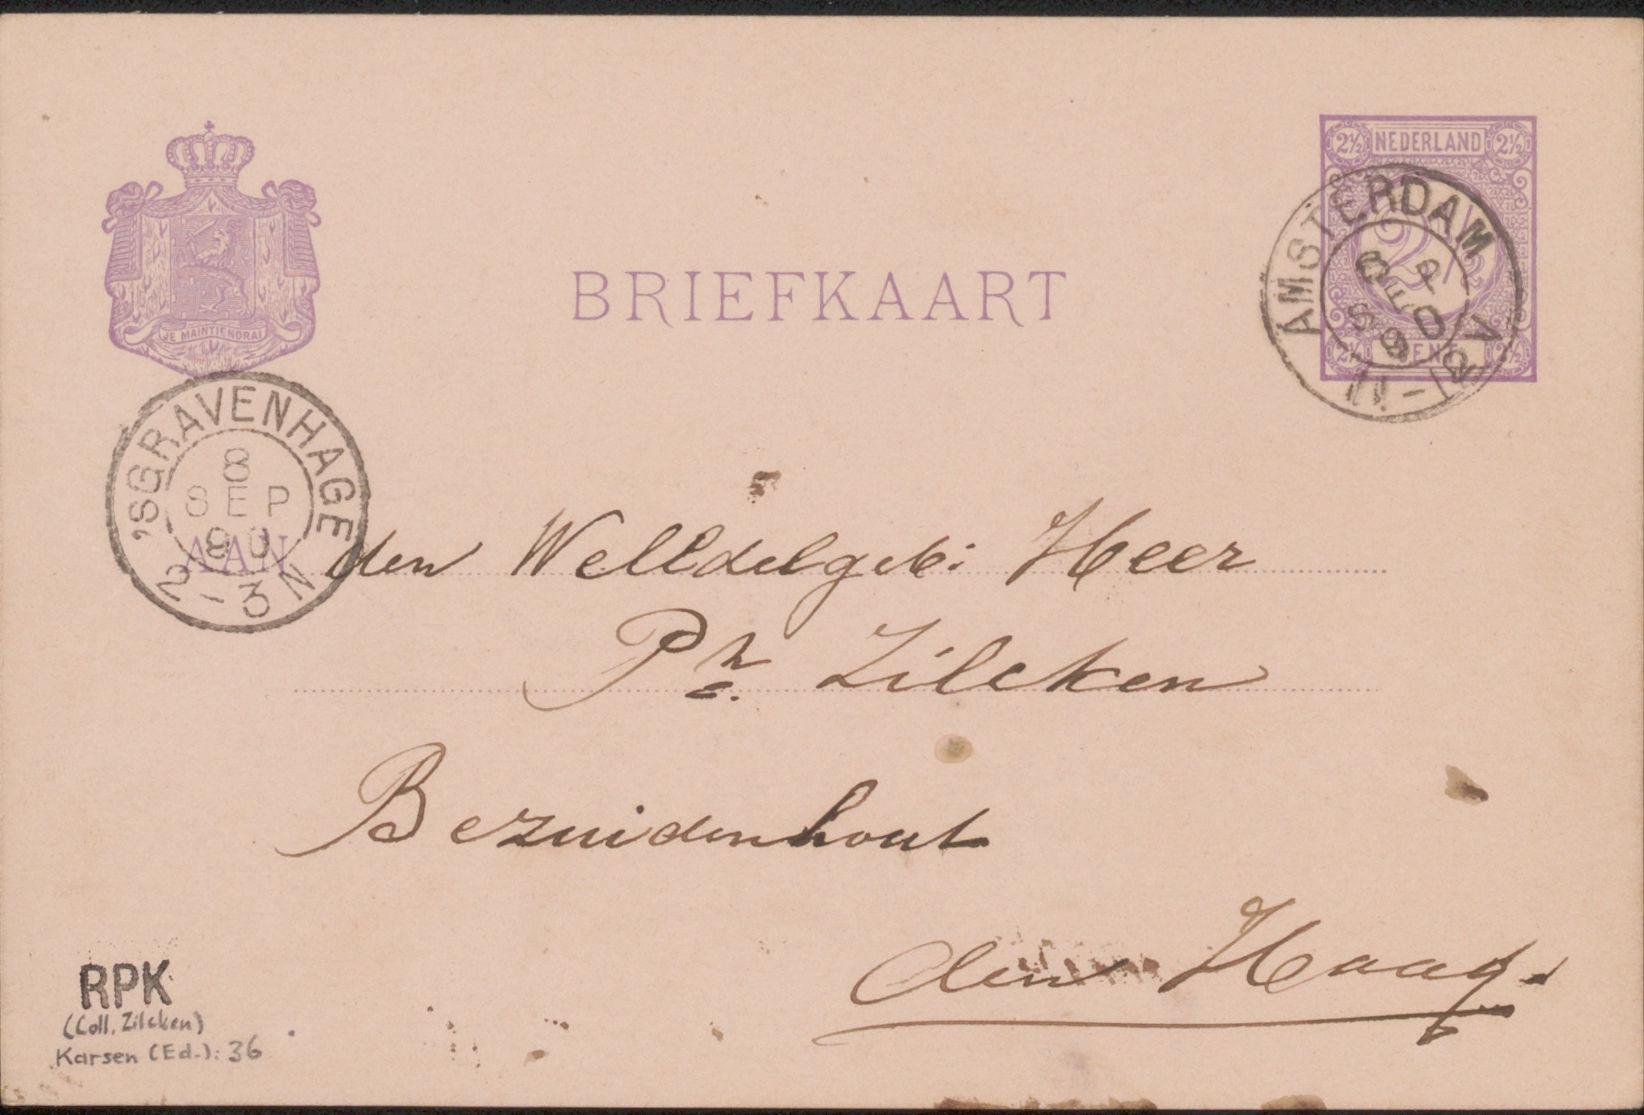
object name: postcard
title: Briefkaart aan Philip Zilcken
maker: eduard karsen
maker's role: draughtsman, painter, print maker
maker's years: 1860-1941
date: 1890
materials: cardboard, ink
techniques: pen, writing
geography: amsterdam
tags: ariette sophia jeannette mauve-carbentus, the hague, painter, draughtsman, philip zilcken, the graphic arts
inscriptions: collector's mark: ‘RPK’